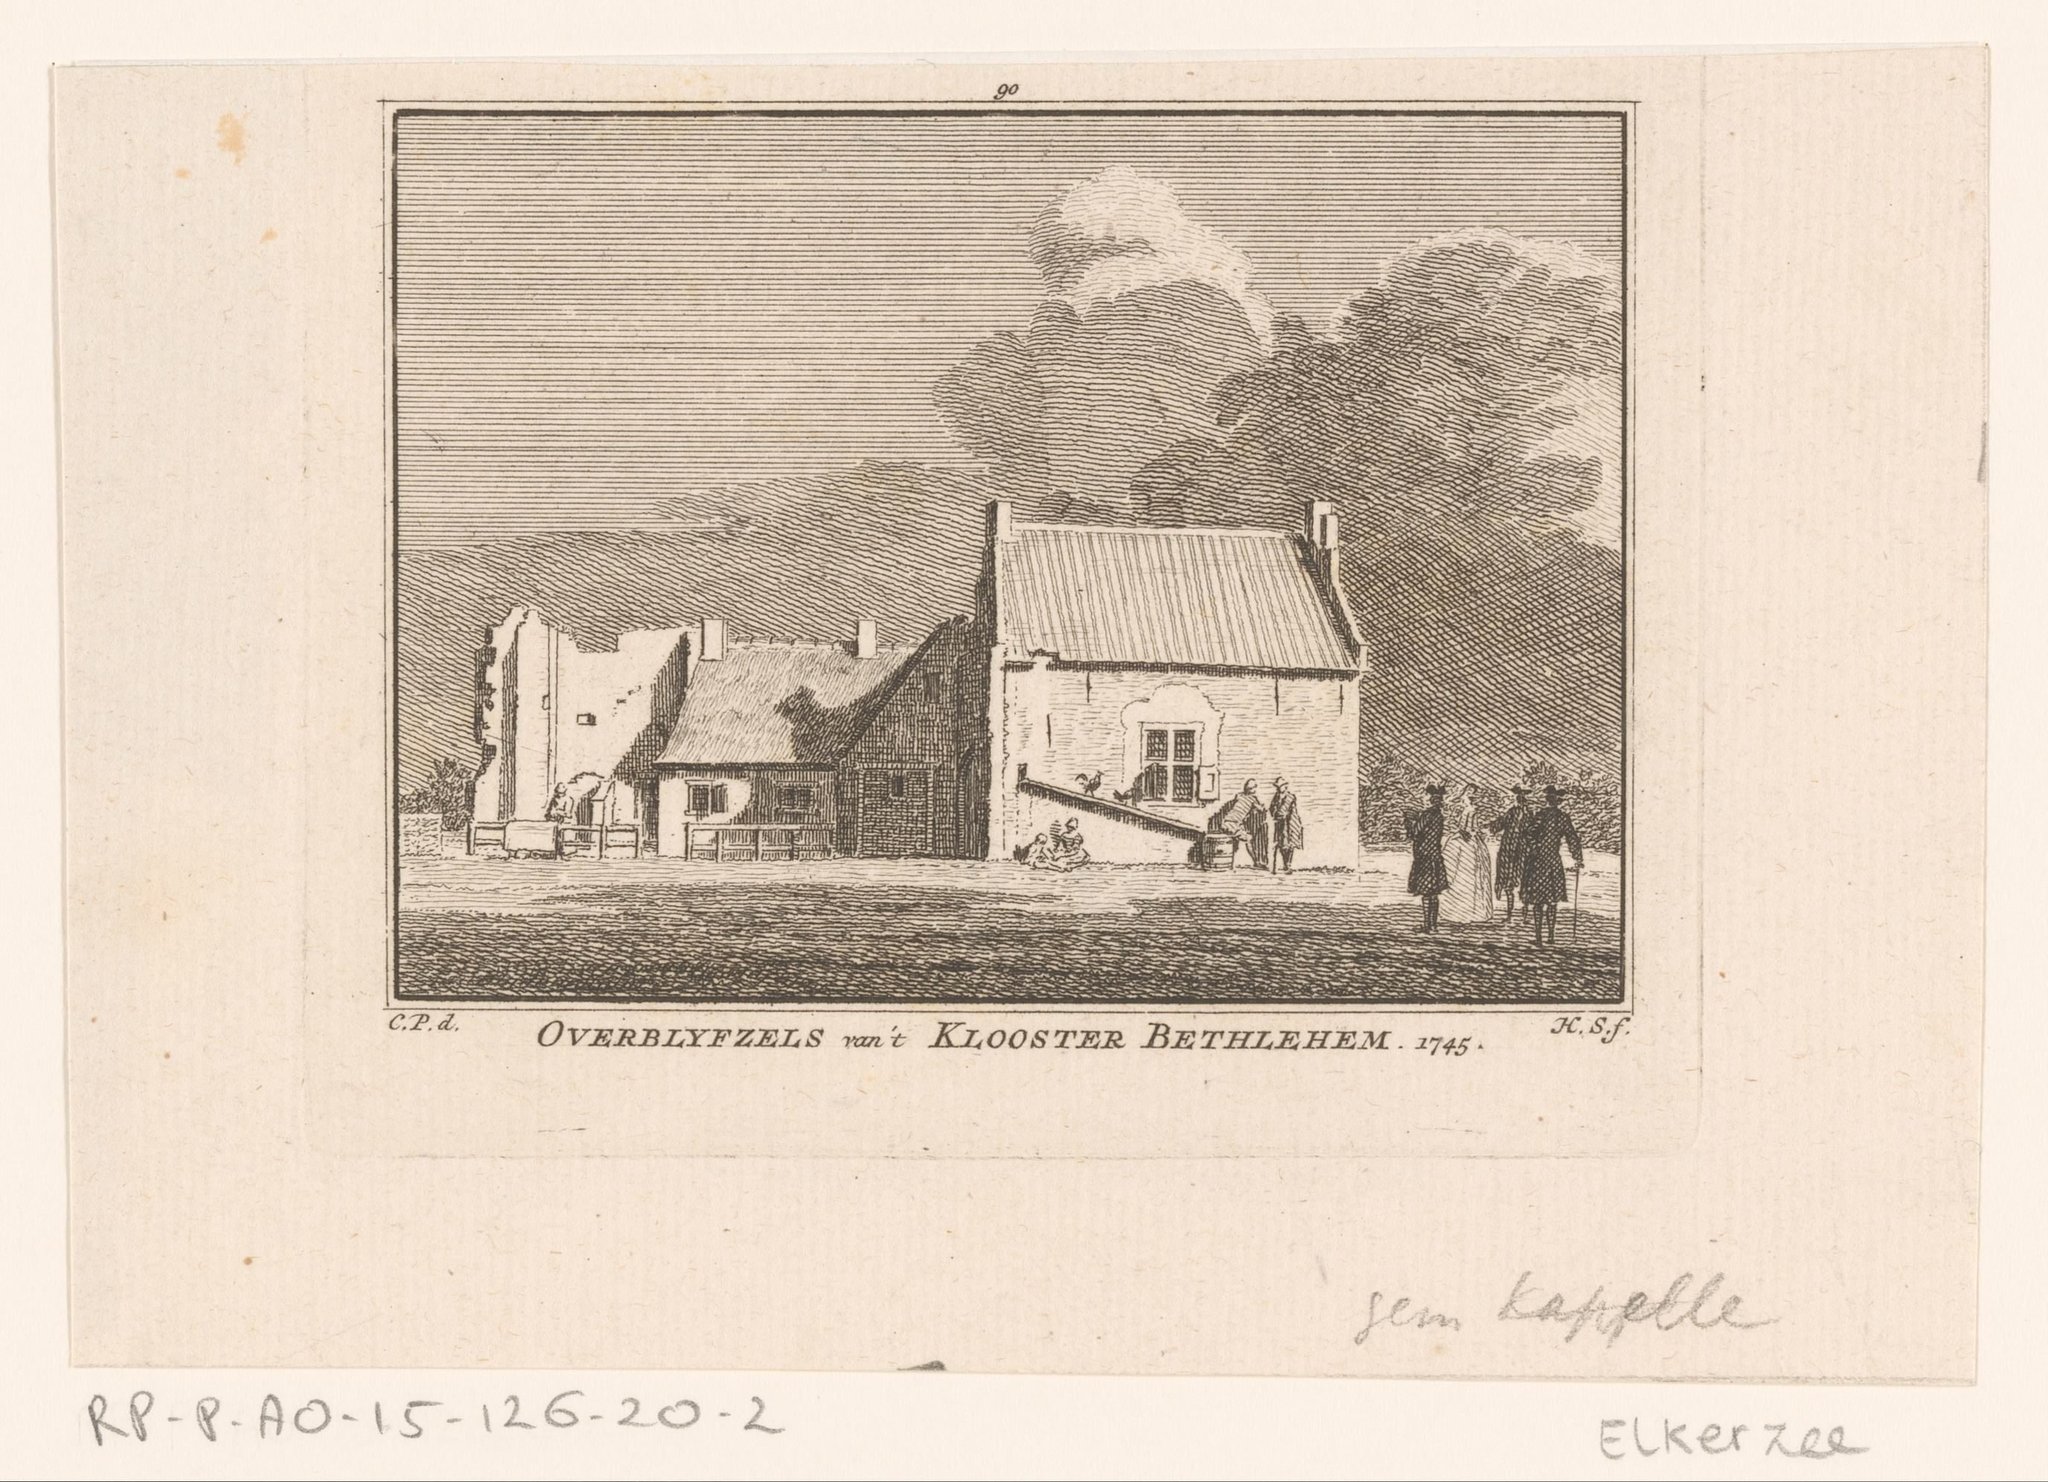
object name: print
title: Overblyfzels van 't Klooster Bethlehem. 1745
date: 1754-1792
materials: paper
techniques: etching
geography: haarlem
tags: ruin of church, monastery, etc.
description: Prent ook gebruikt in: Het verheerlykt Nederland of kabinet van hedendaagsche gezigten van steden, dorpen (…). 9 delen. Amsterdam: Isaak Tirion en weduwe Isaak Tirion, 1745-1774, dl. 5 (1754), ill. 90. Of in: Nederlandsche tafereelen; of eene keurige verzameling van negen honderd fraaije gezigten van steden, dorpen, sloten, oudheden [….]. 9 delen. Amsterdam: Jan de Groot, 1792, dl. 5, ill. 90.